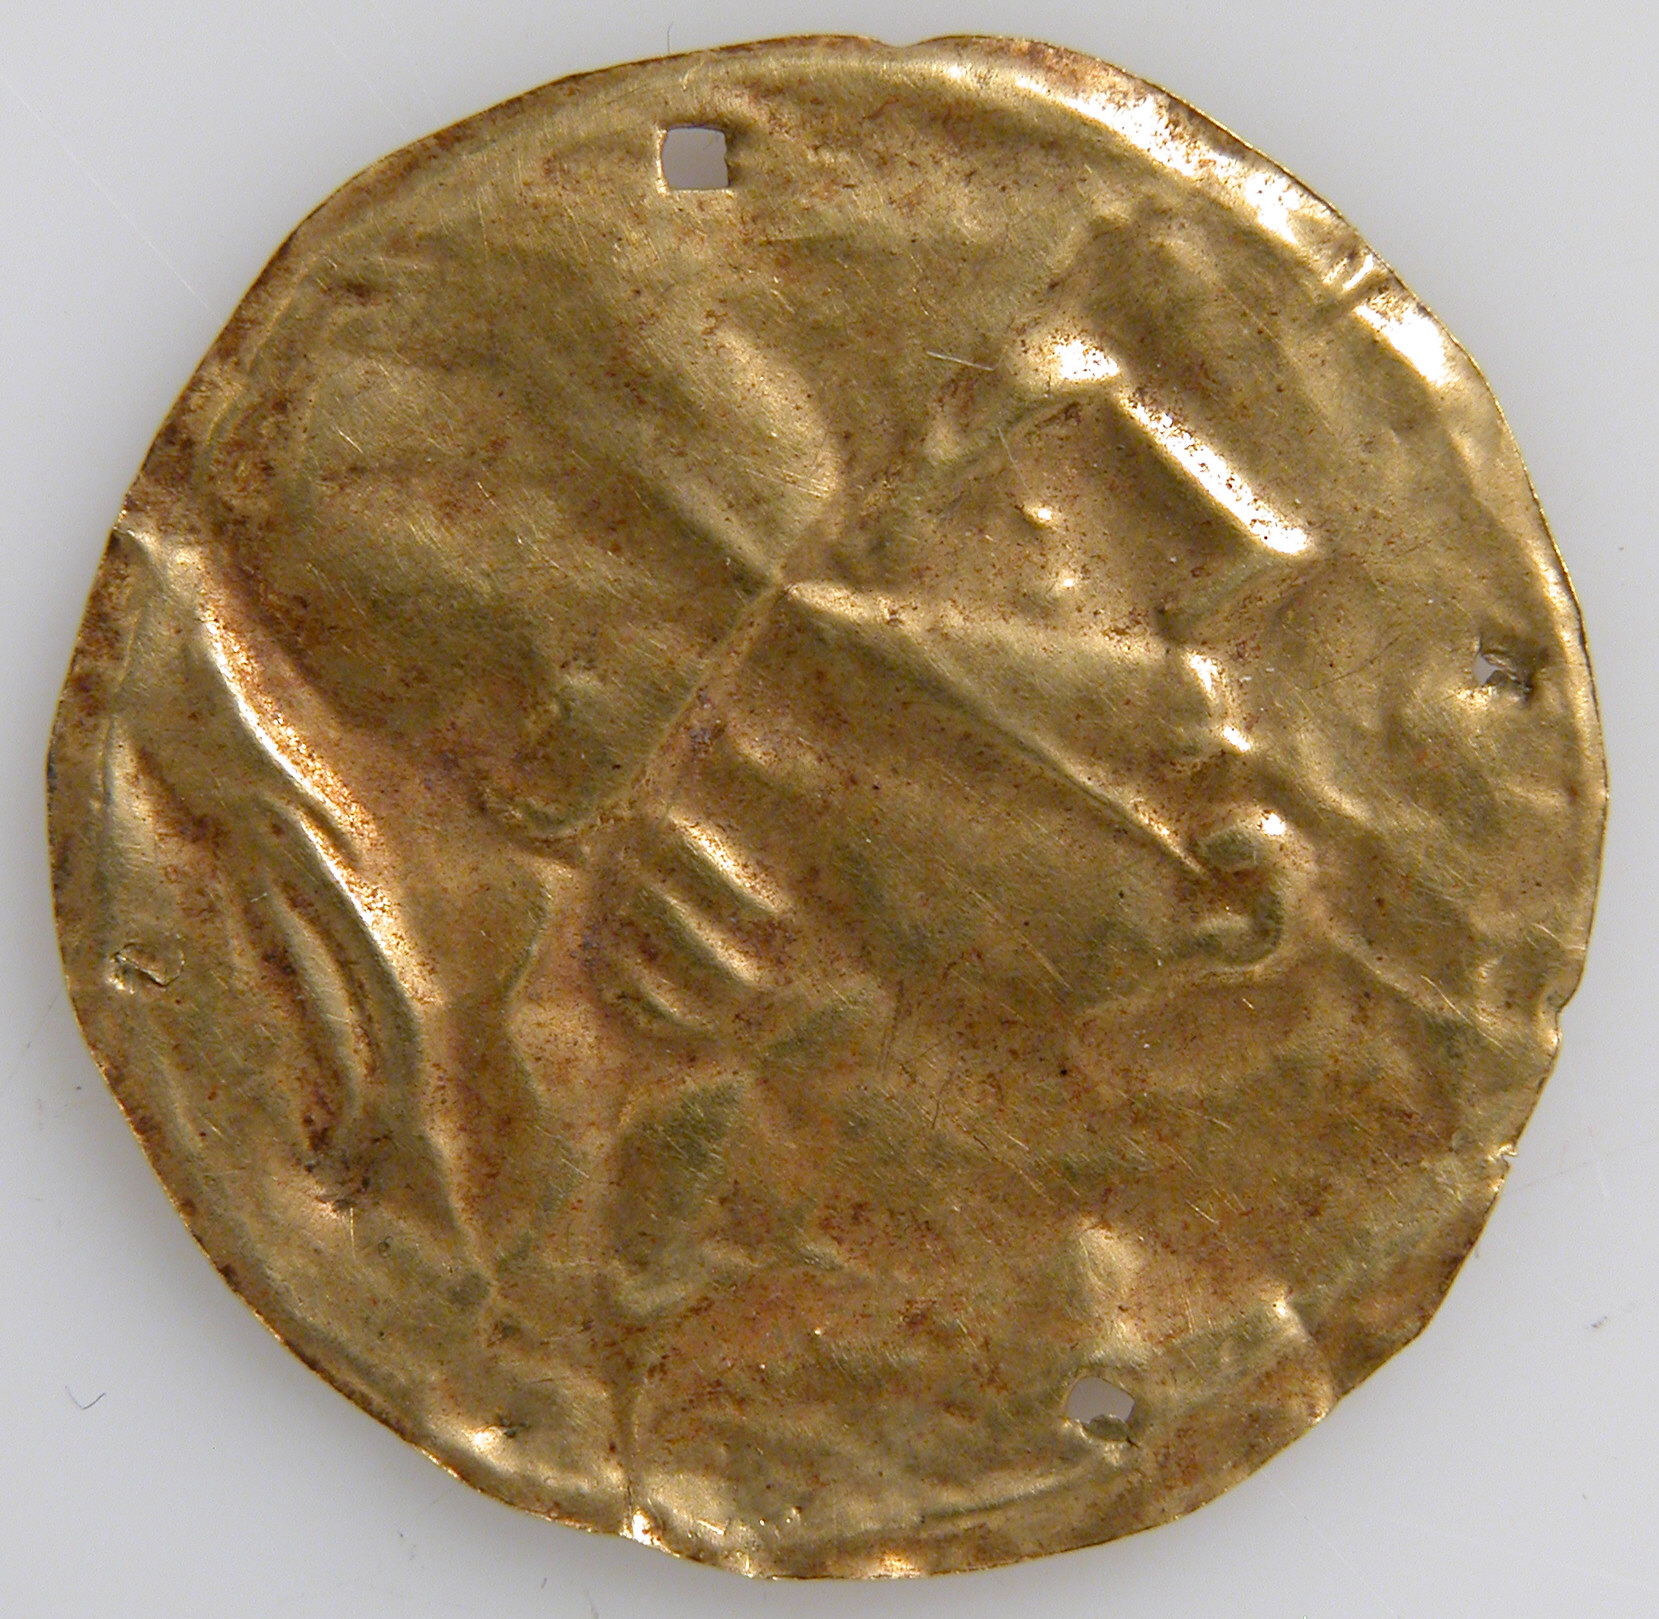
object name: bracteate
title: Bracteate with Human Head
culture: roman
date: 200-500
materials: gold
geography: gaul